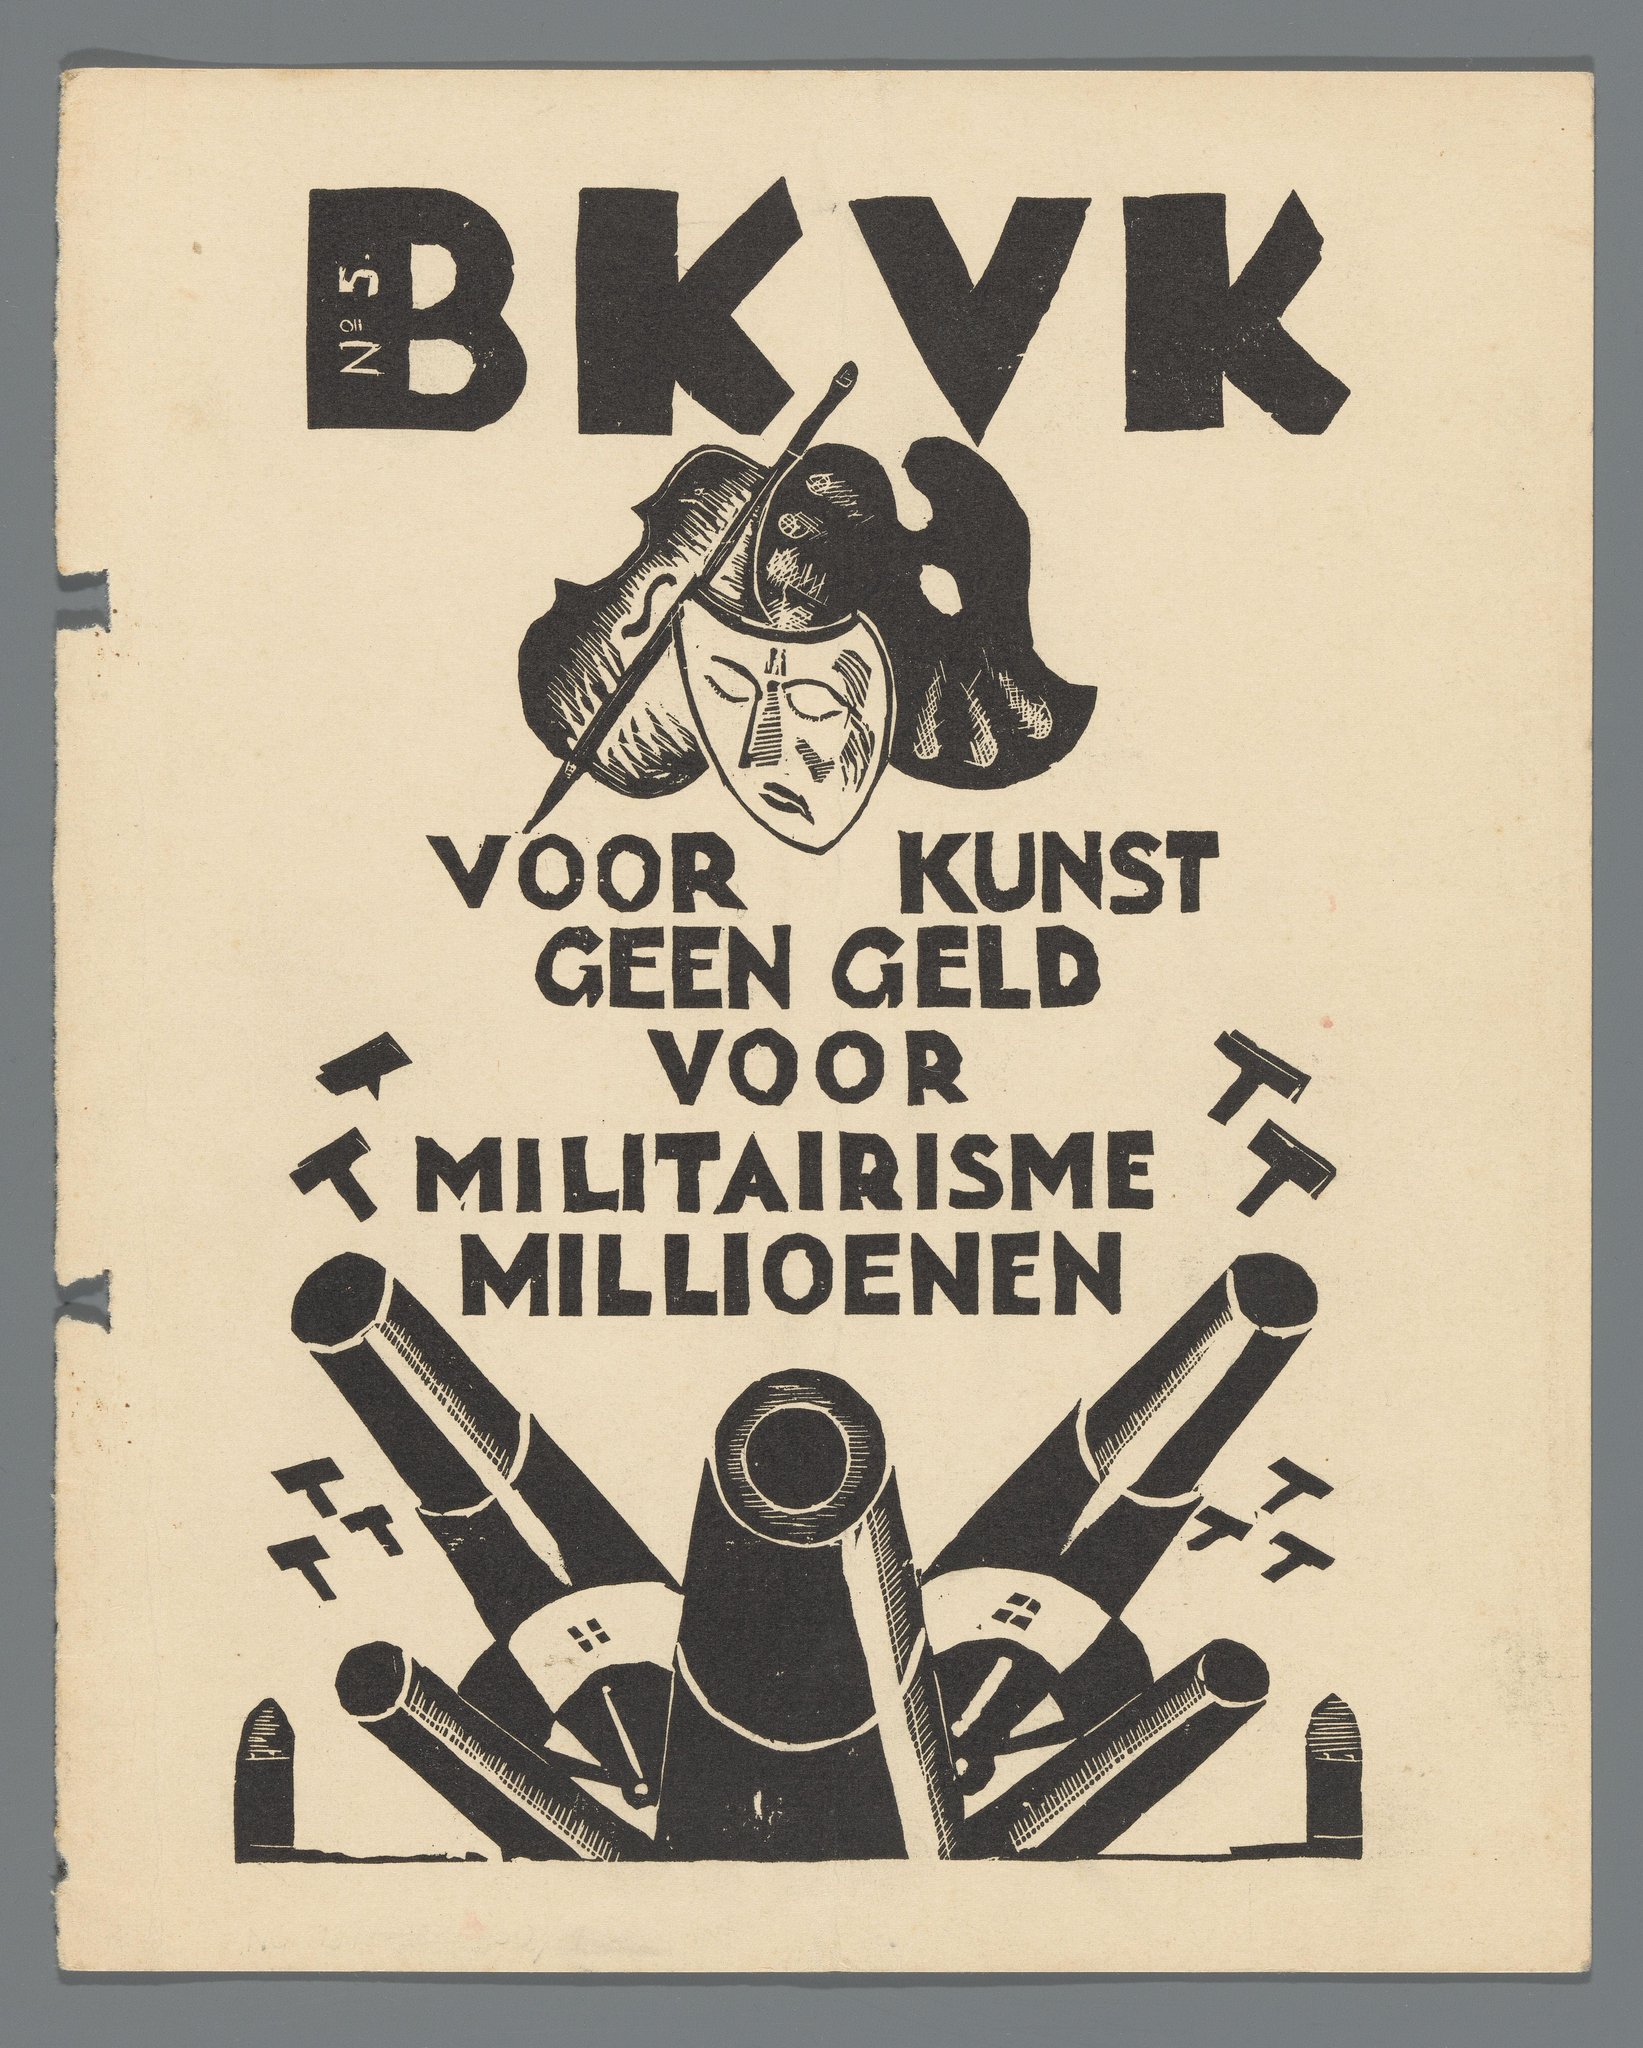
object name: wrapper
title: Magazine Covers Bond van Kunstenaars ter verdediging van de Kulturele Rechten (Association of Artists in Defence of Cultural Rights)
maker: Anonymous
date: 1936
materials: paper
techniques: linocut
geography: netherlands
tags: disarmament, symbolic representations, allegories and emblems ~ art; 'arte' (ripa)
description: In 1935, a group of Dutch, left-wing artists campaigned against the rise of fascism. Human rights, the constitution, and art subsidies were under threat. Militarism, war, nationalism, violence and oppression threatened. The artists formed a union that organized lectures and protest exhibitions. These pages are from their bulletin calling for resistance.